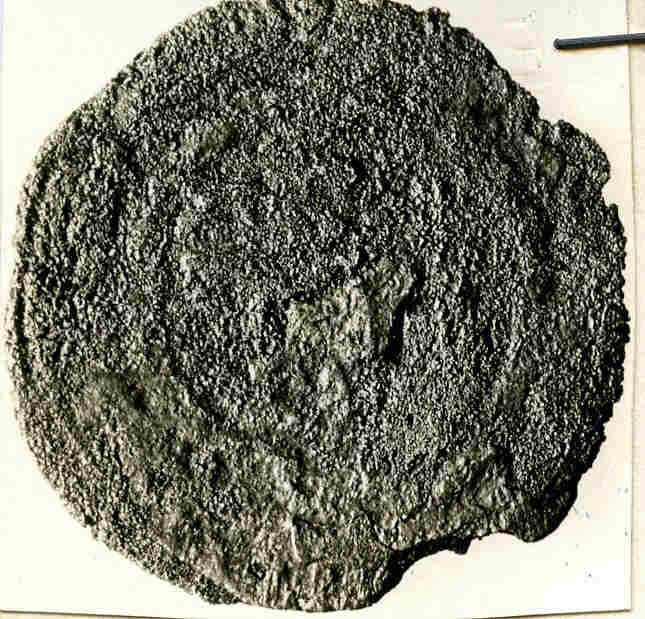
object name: coin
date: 758-768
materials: copper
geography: iran